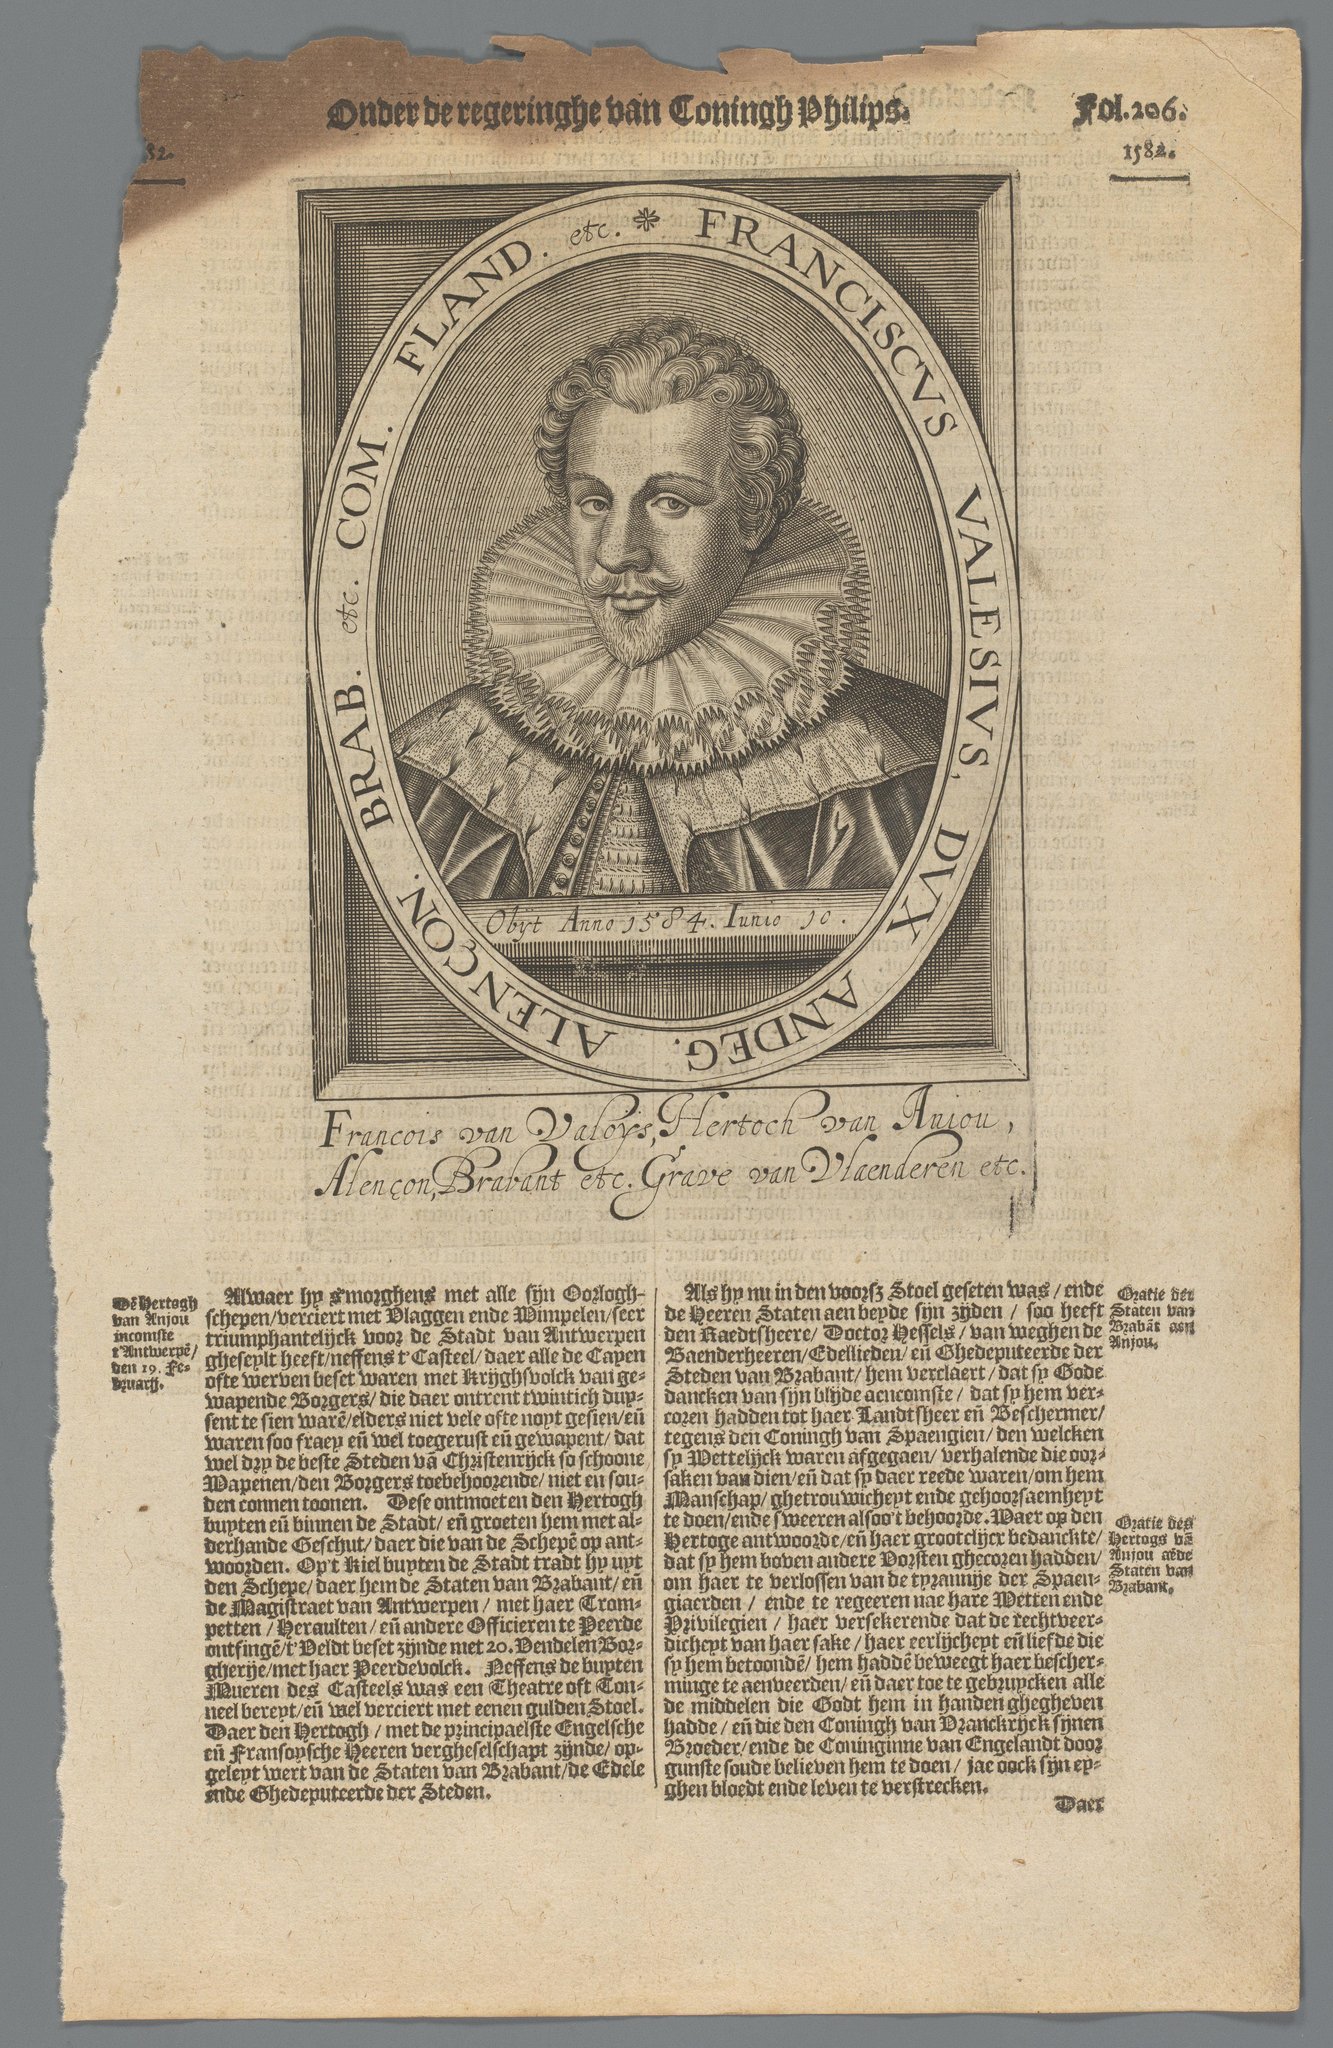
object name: book illustration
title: Portret van Frans Hercules van Anjou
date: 1614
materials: paper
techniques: engraving, letterpress printing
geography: the hague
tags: historical persons, nobility and patriciate; chivalry, knighthood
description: Prent uit: Meteren, Emanuel van. Historie der Nederlandscher ende haerder na-buren oorlogen ende geschiedenissen (...). Den Haag: Hillebrant Iacobsz. van Wouw, 1614.